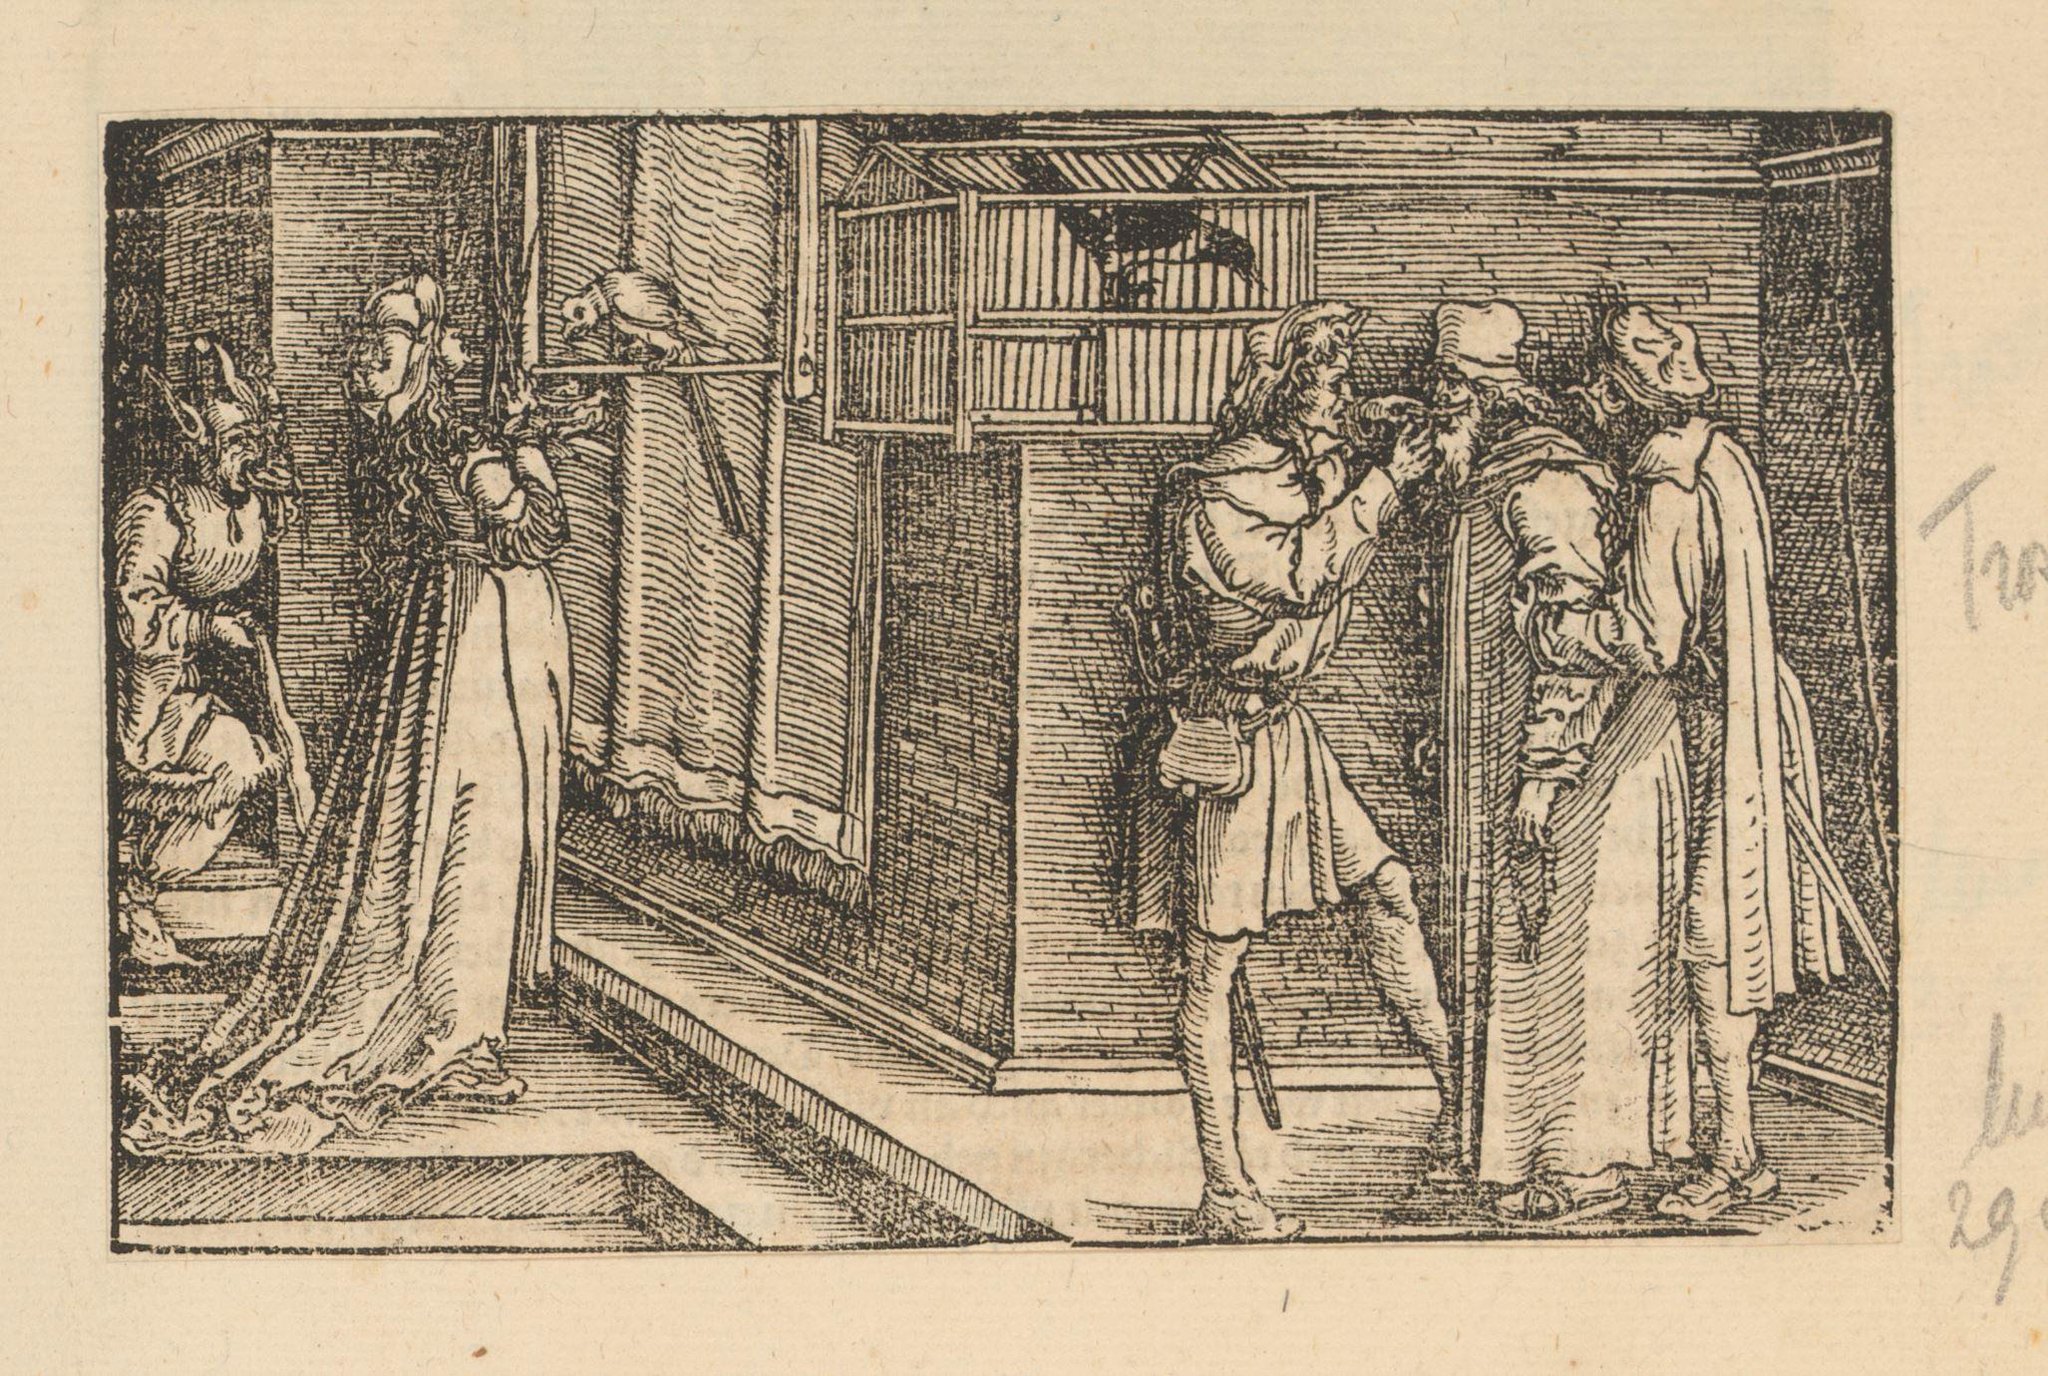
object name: album leaf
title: Meisje en nar bij een volière en een man wordt de tong uitgesneden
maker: Anonymous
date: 1514-1532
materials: paper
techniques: letterpress printing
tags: violent death by blinding - ee - death not certain; wounded person, bird in a cage (+ feeding animal)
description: Deze prent is gebruikt in: Petrarca, Francesco. Von der Artzney bayder Glück, des guten und widerwertigen: unnd weß sich ain yeder inn Gelück und Unglück halten sol (...). Augsburg: Heinrich Steiner, 1532. Deze uitgave is ook bekend onder de titel 'Trostspiegel in Glück und Unglück'.